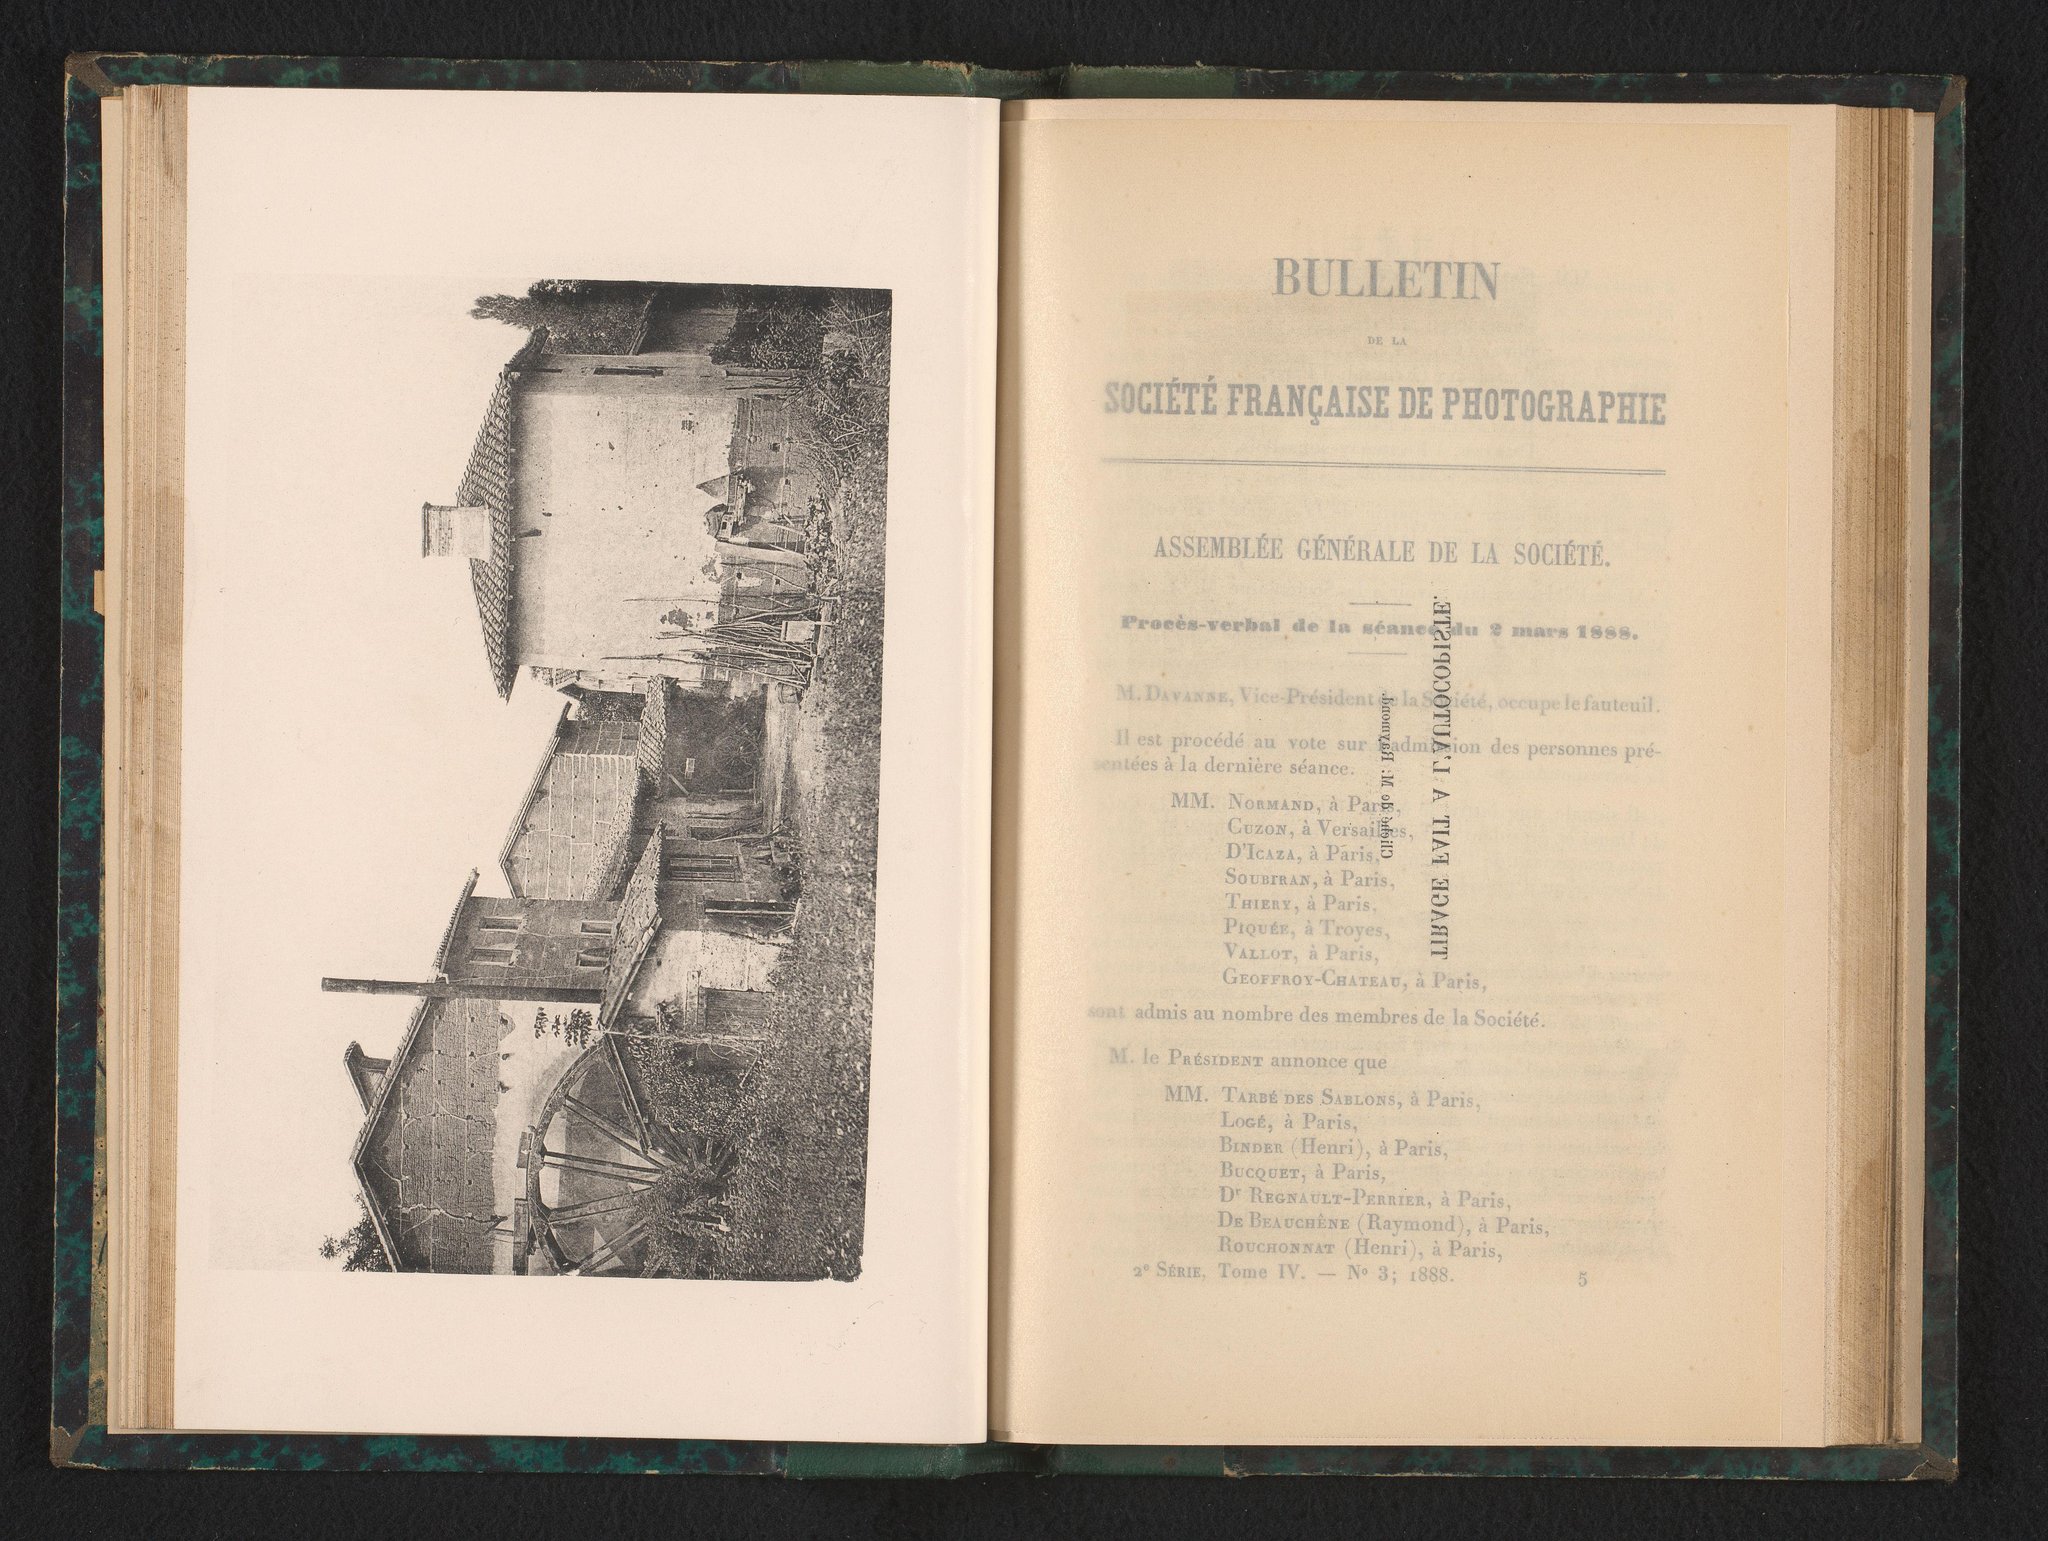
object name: photograph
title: Gezicht op een groep huizen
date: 1883-1888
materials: ink, paper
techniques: hectograph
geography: france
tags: urban housing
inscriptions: inscription: ‘Tirage fait à l'autocopiste.’